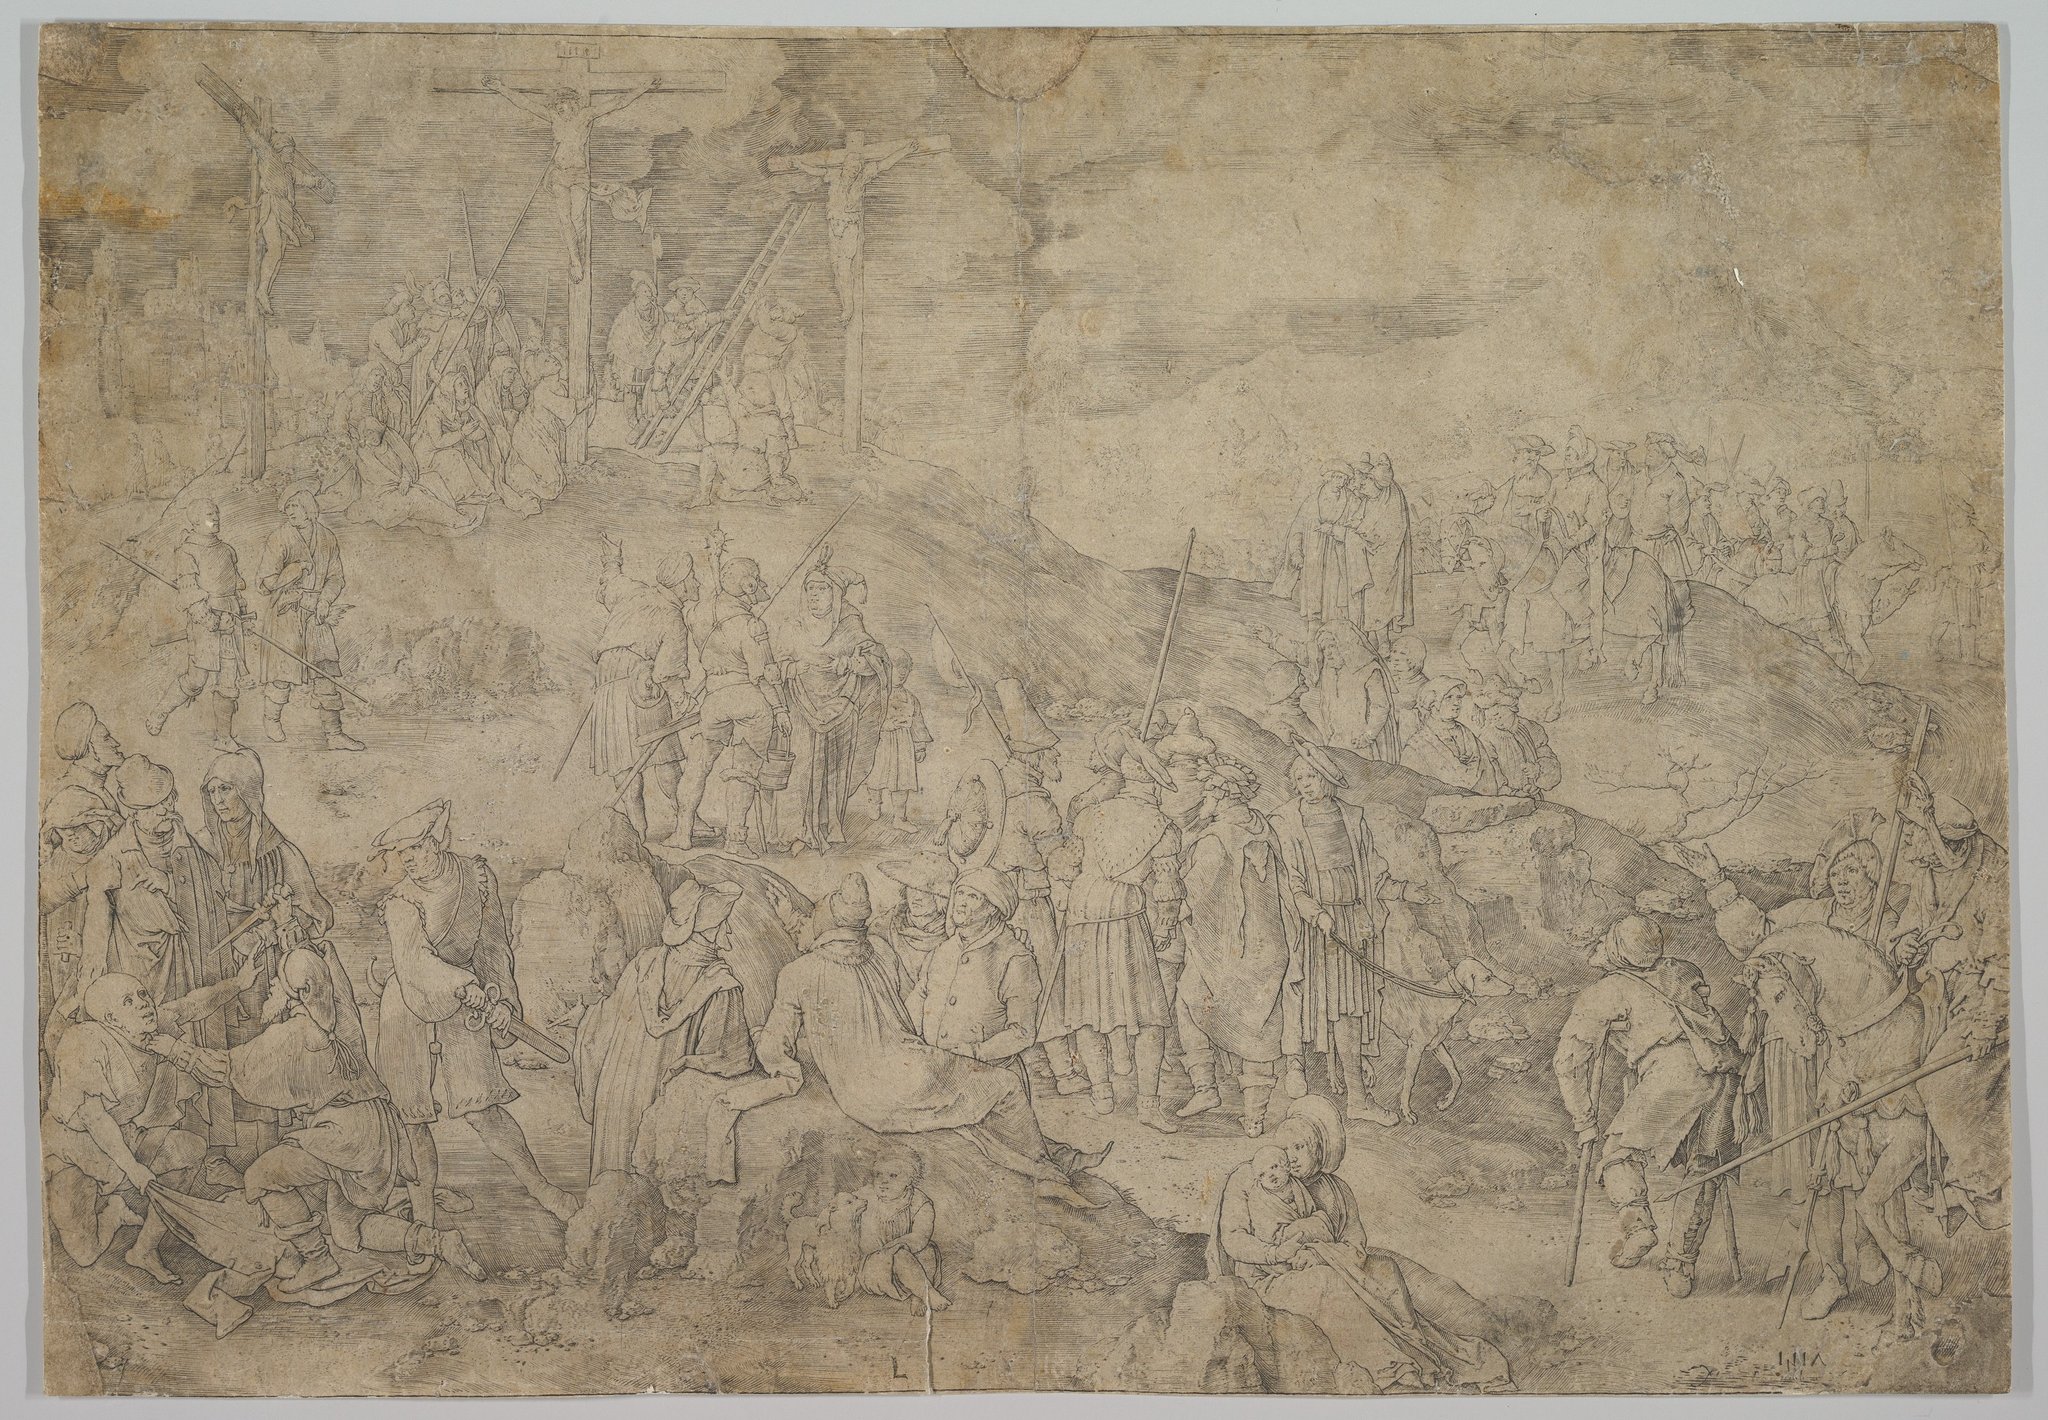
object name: print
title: Calvary (Golgotha)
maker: lucas van leyden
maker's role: artist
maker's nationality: netherlandish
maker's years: 1494-1533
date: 1517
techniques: engraving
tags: crucifixion